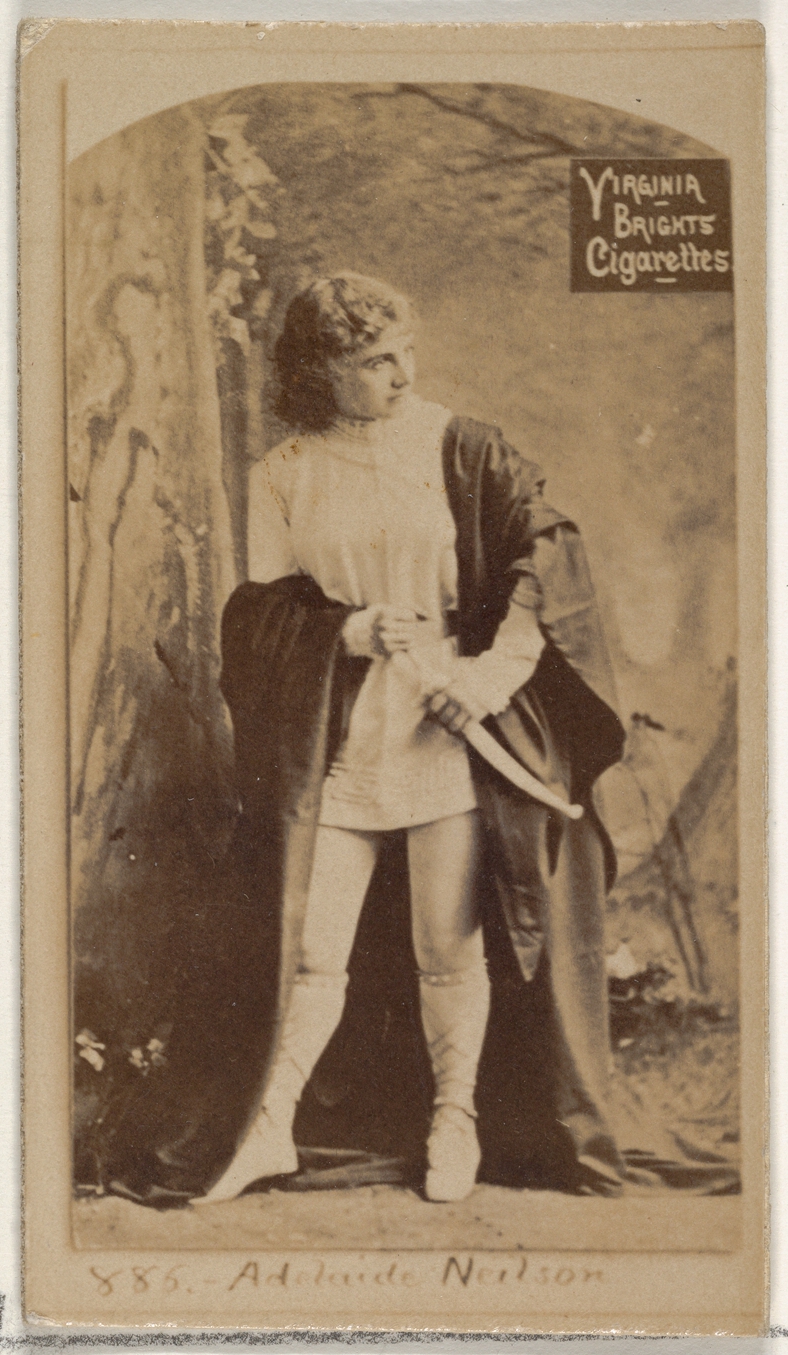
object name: photograph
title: Card 886, Adelaide Neilson, from the Actors and Actresses series (N45, Type 2) for Virginia Brights Cigarettes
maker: allen & ginter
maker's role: publisher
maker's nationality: american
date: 1888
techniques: albumen silver print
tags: portraits,women,actresses